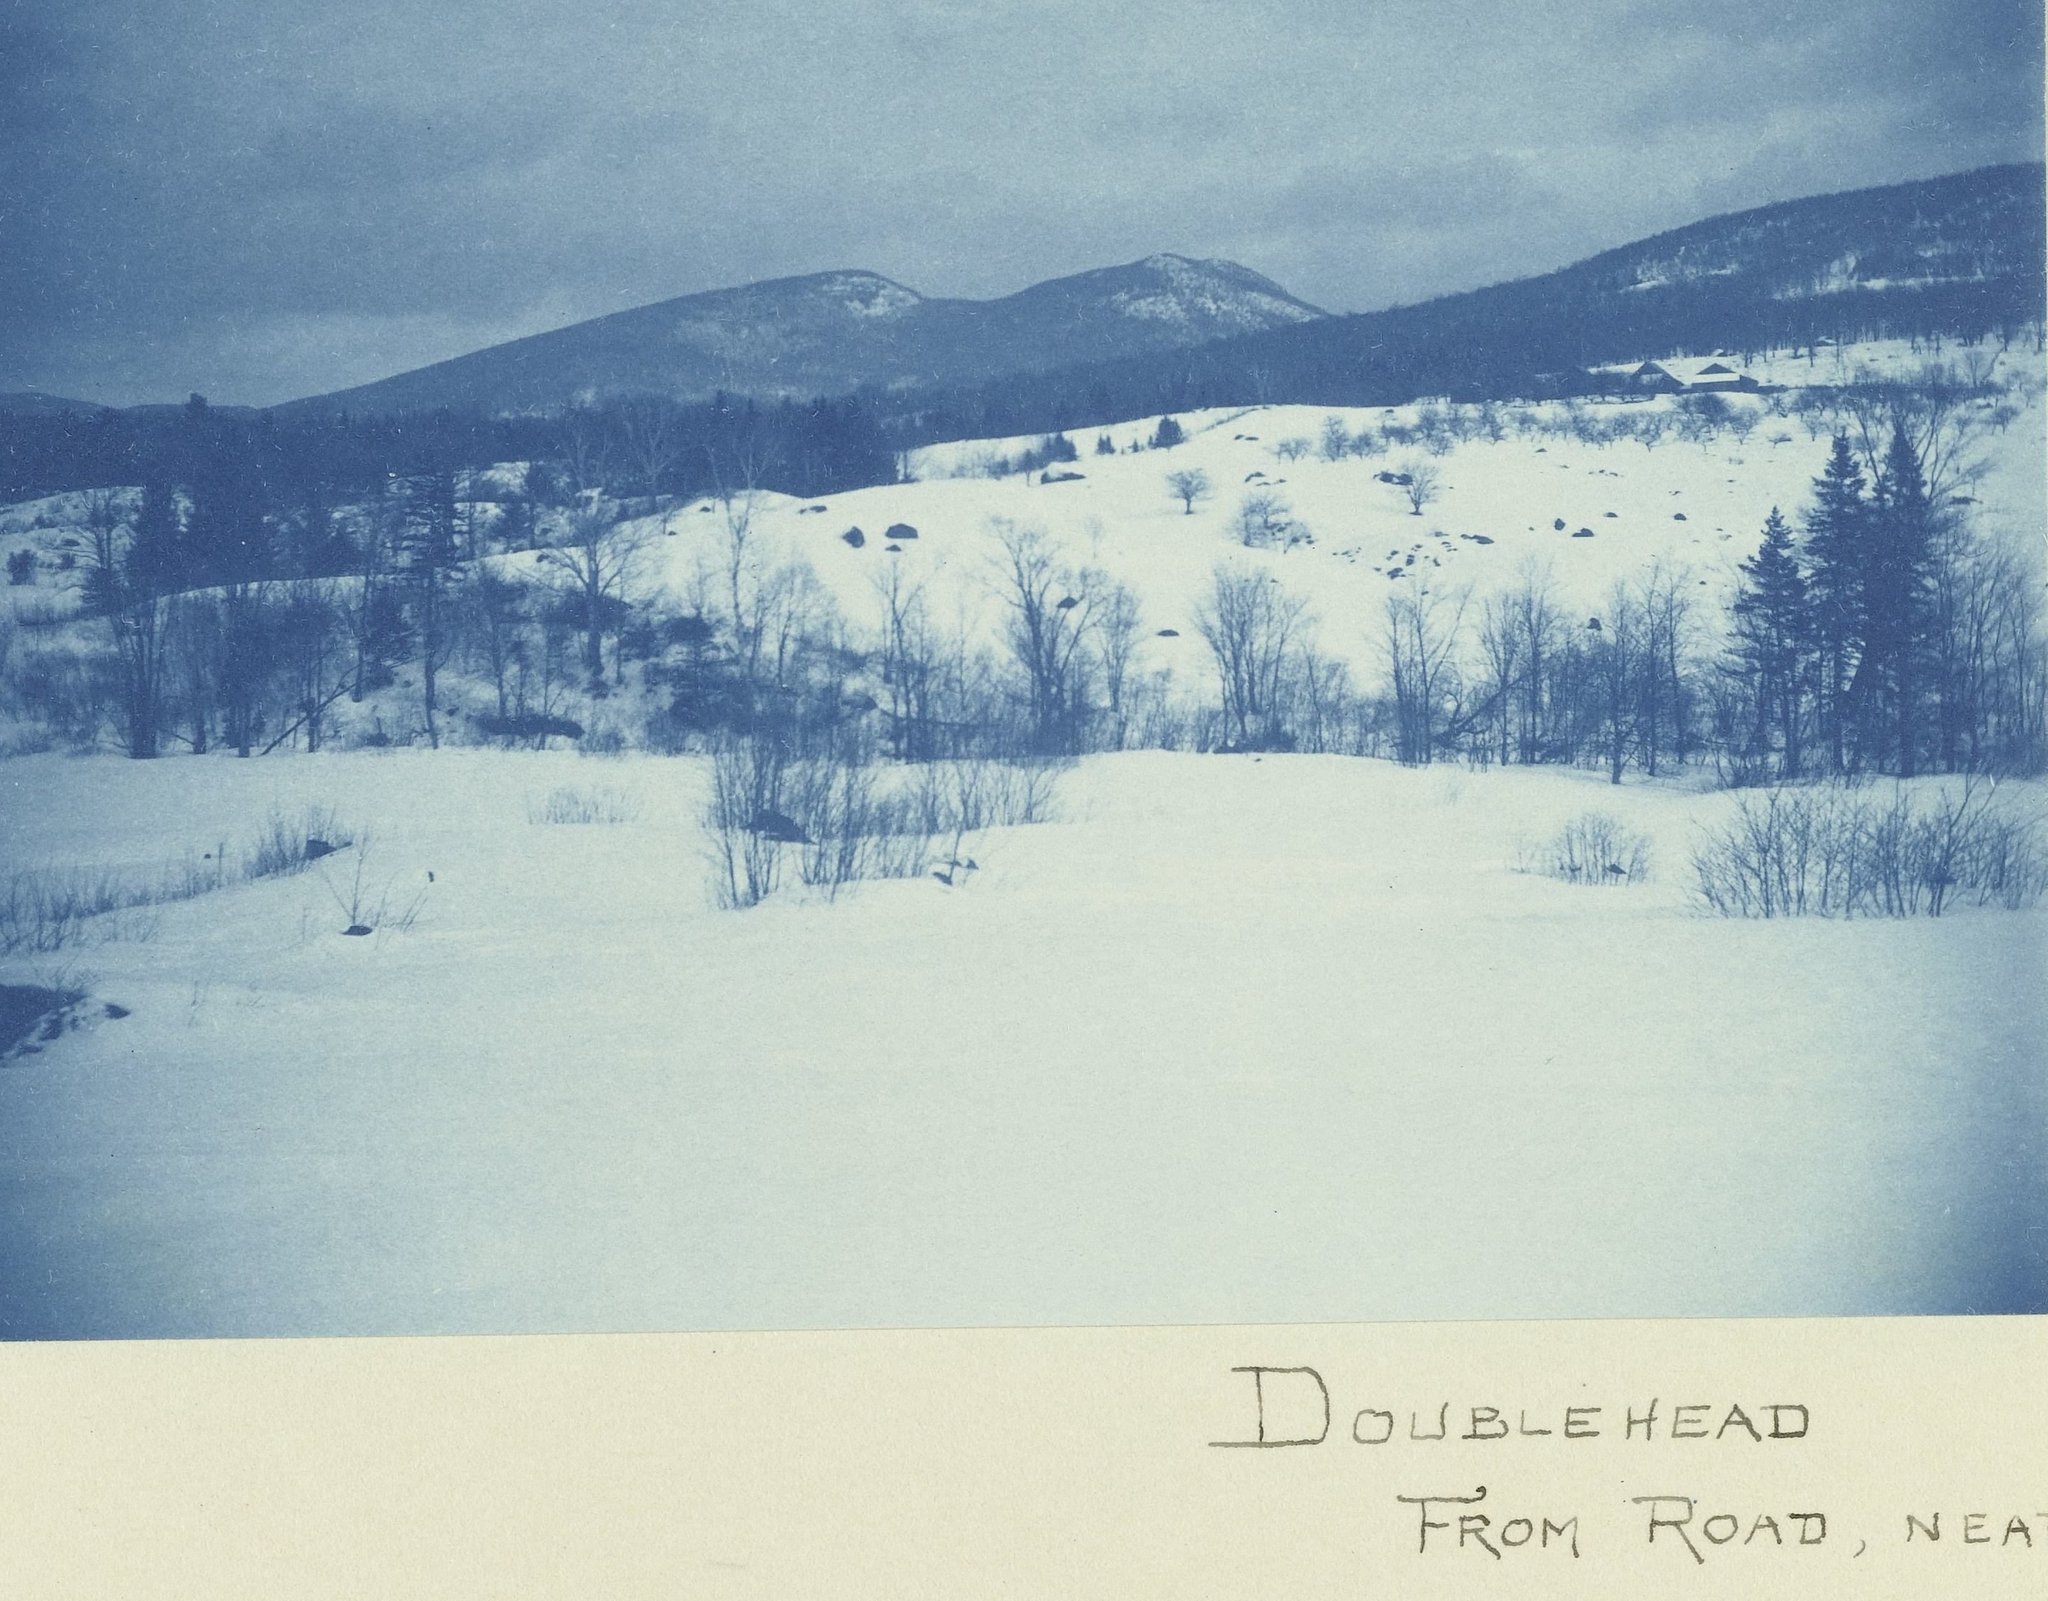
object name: photograph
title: Landschap in de sneeuw: Doublehead, gezien vanaf een weg nabij Gale's, NH, Verenigde Staten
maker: charlotte m. endicott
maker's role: fotograaf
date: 1899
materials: photographic support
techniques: cyanotype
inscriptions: title: ‘DOUBLEHEAD / FROM ROAD, NEAR GALE'S / FEB. 21. 1899’